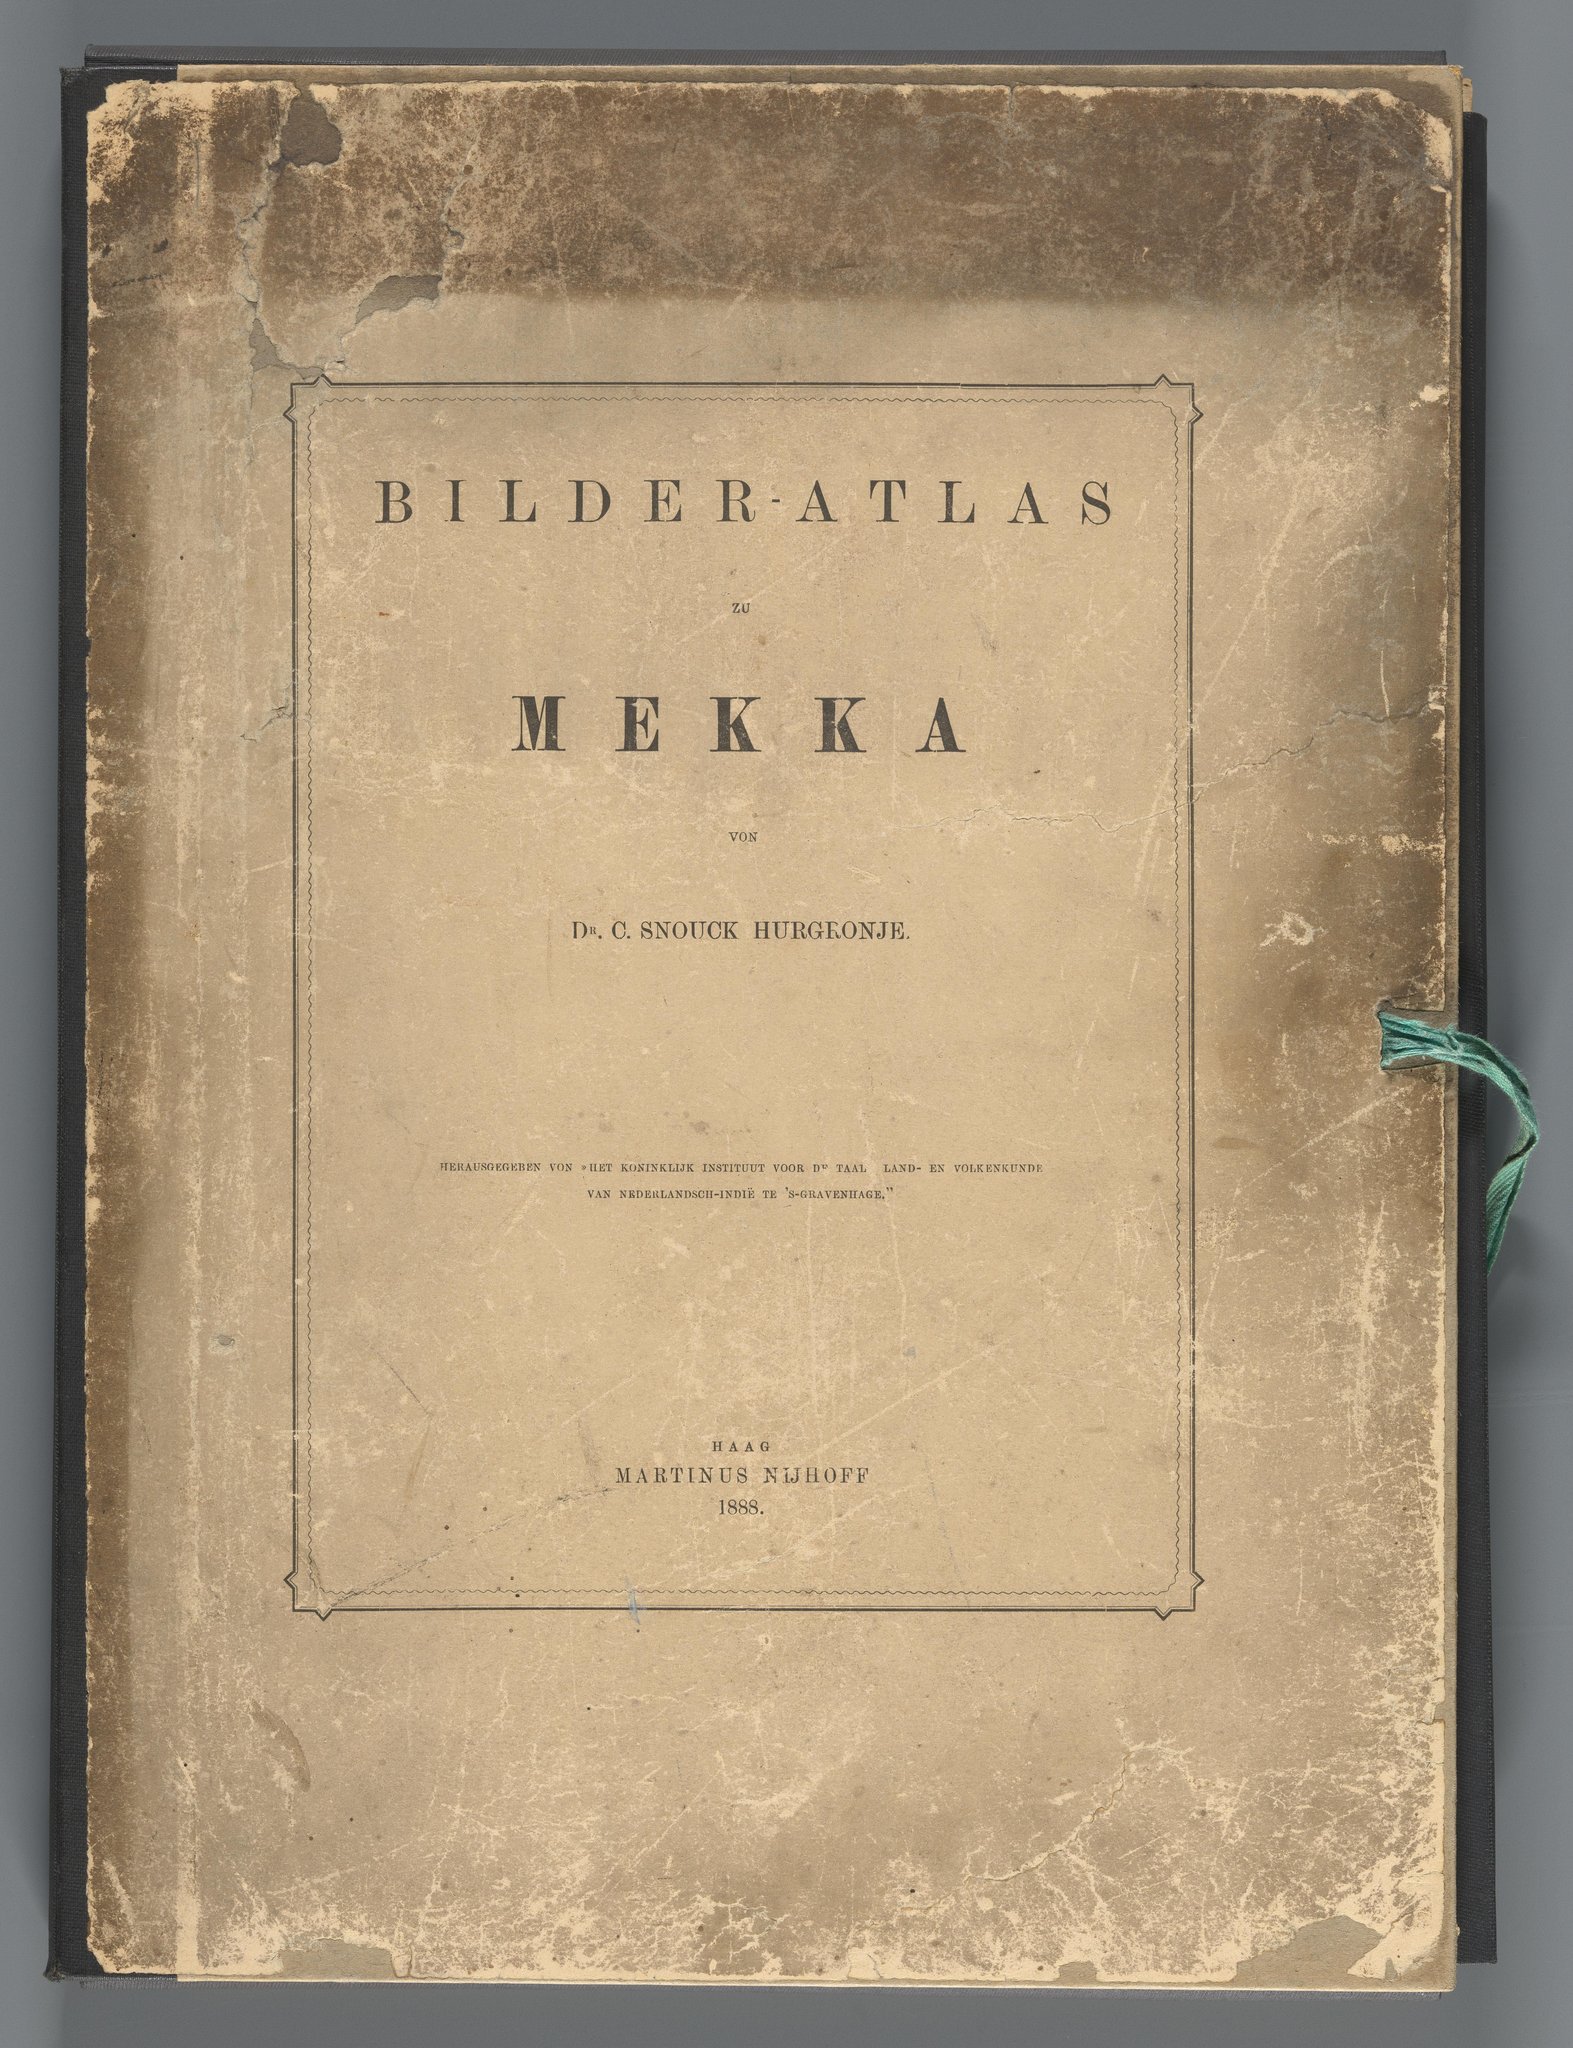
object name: wrapper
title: Bilder-Atlas zu Mekka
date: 1888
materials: cardboard, paper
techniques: photograph, lithograph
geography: the hague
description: Omslag voor 65 lichtdrukken en 13 lithografieën op 43 bladen.